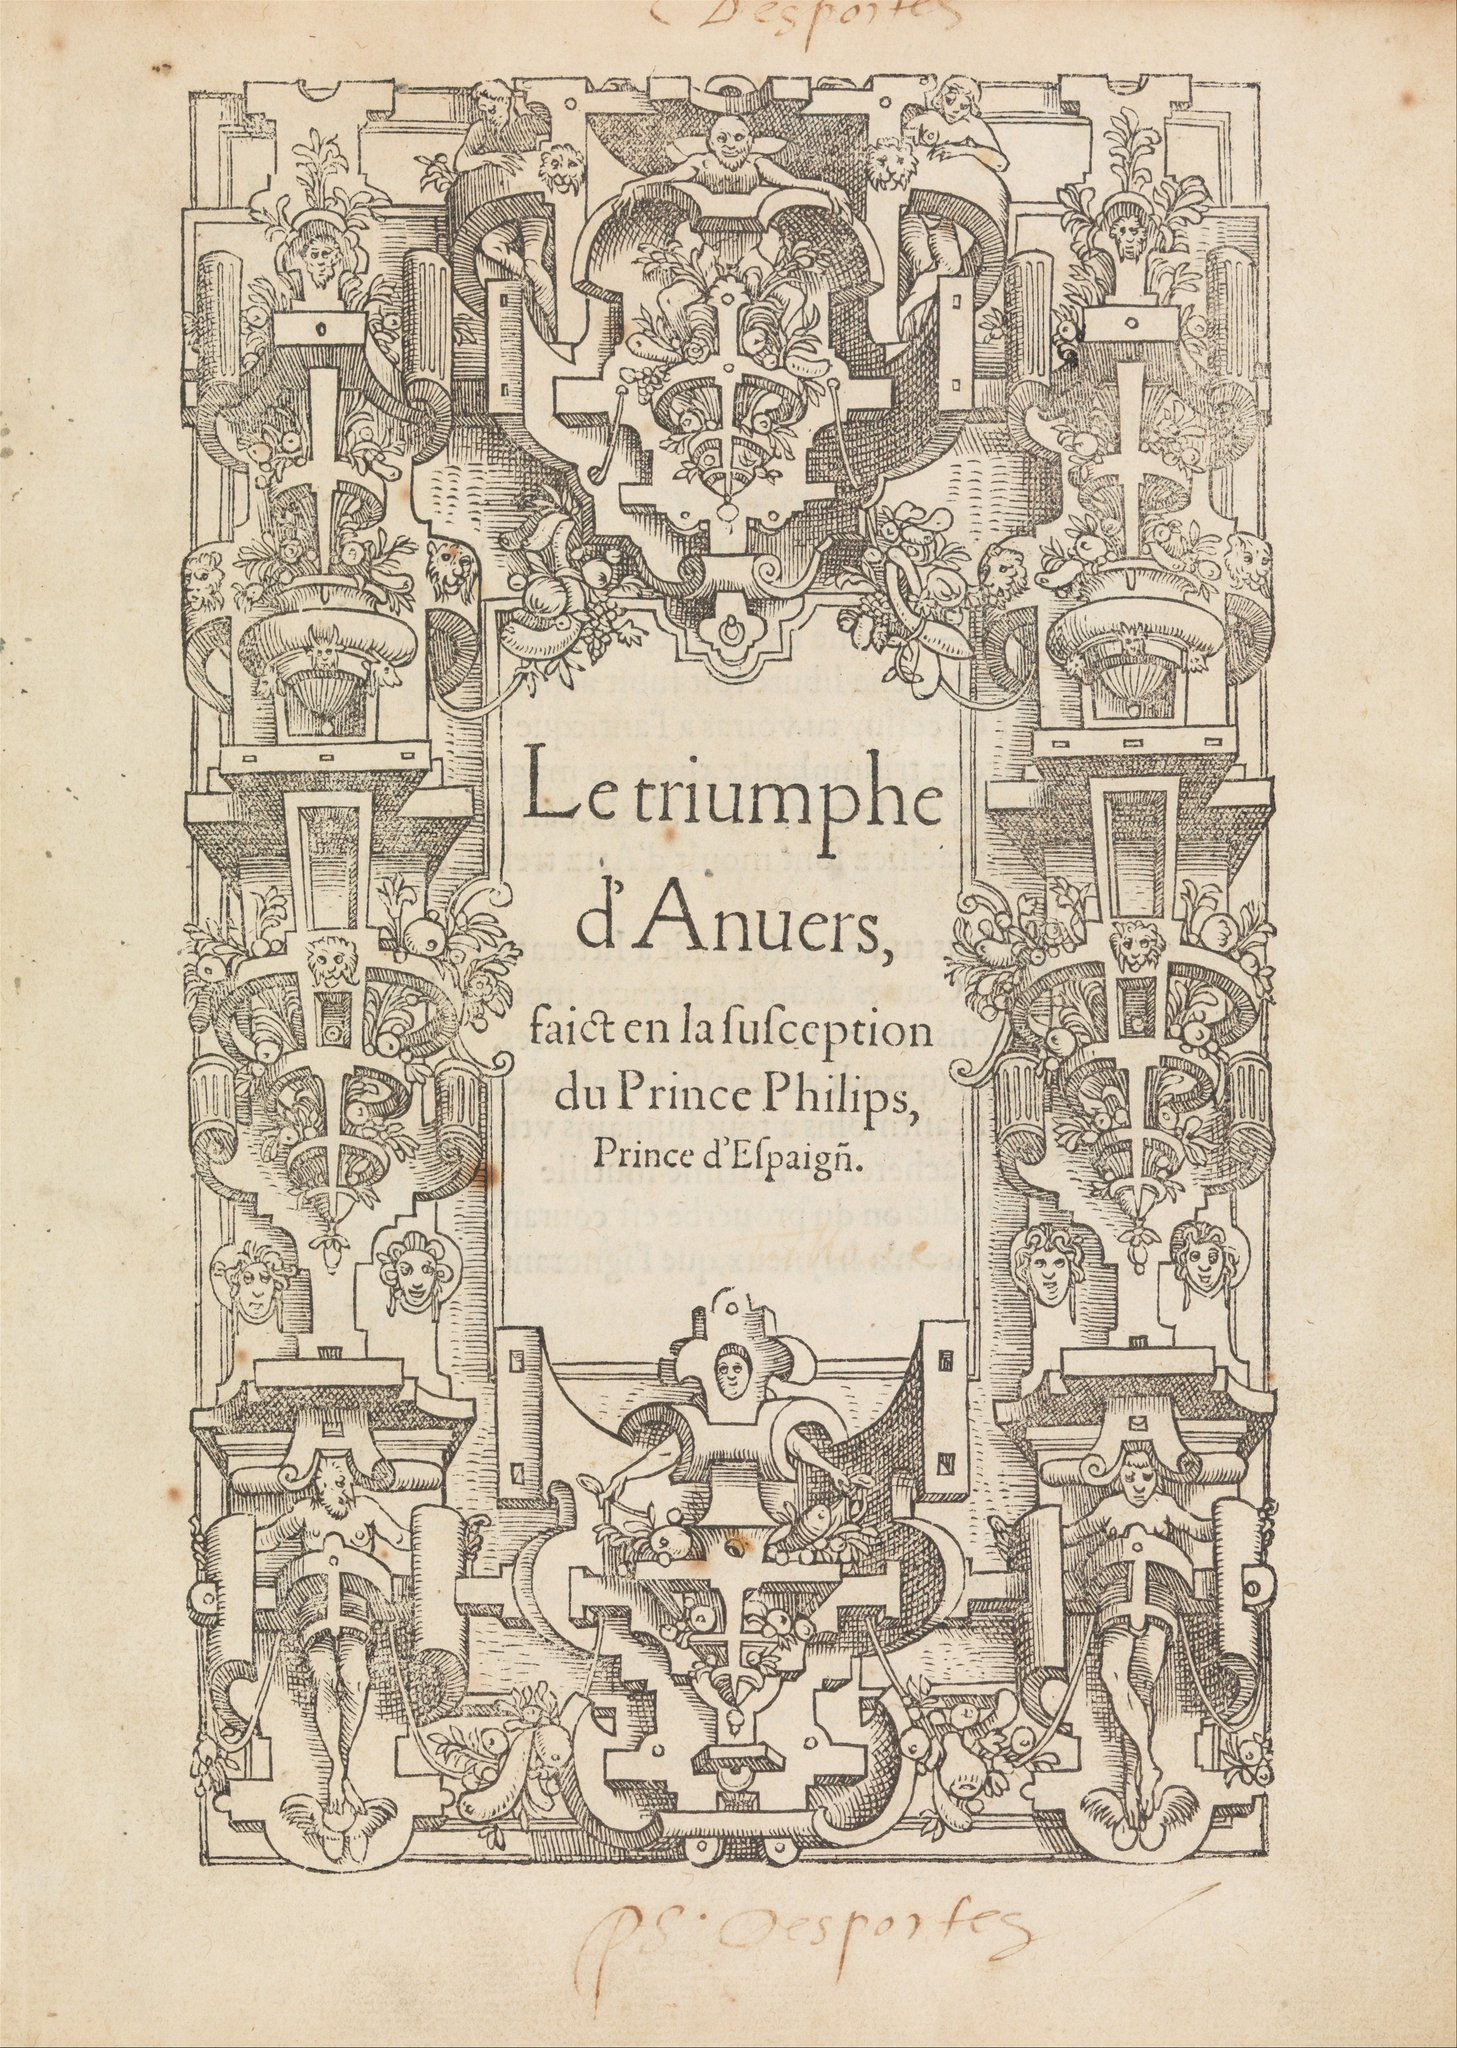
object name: book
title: Le triomphe d'Anvers faict en la susception du Prince Philips, Prince d'Espaign[e]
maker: pieter coecke van aelst (i)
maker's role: artist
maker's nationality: netherlandish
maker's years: 1502-1550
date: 1550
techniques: woodcut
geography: belgium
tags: faces